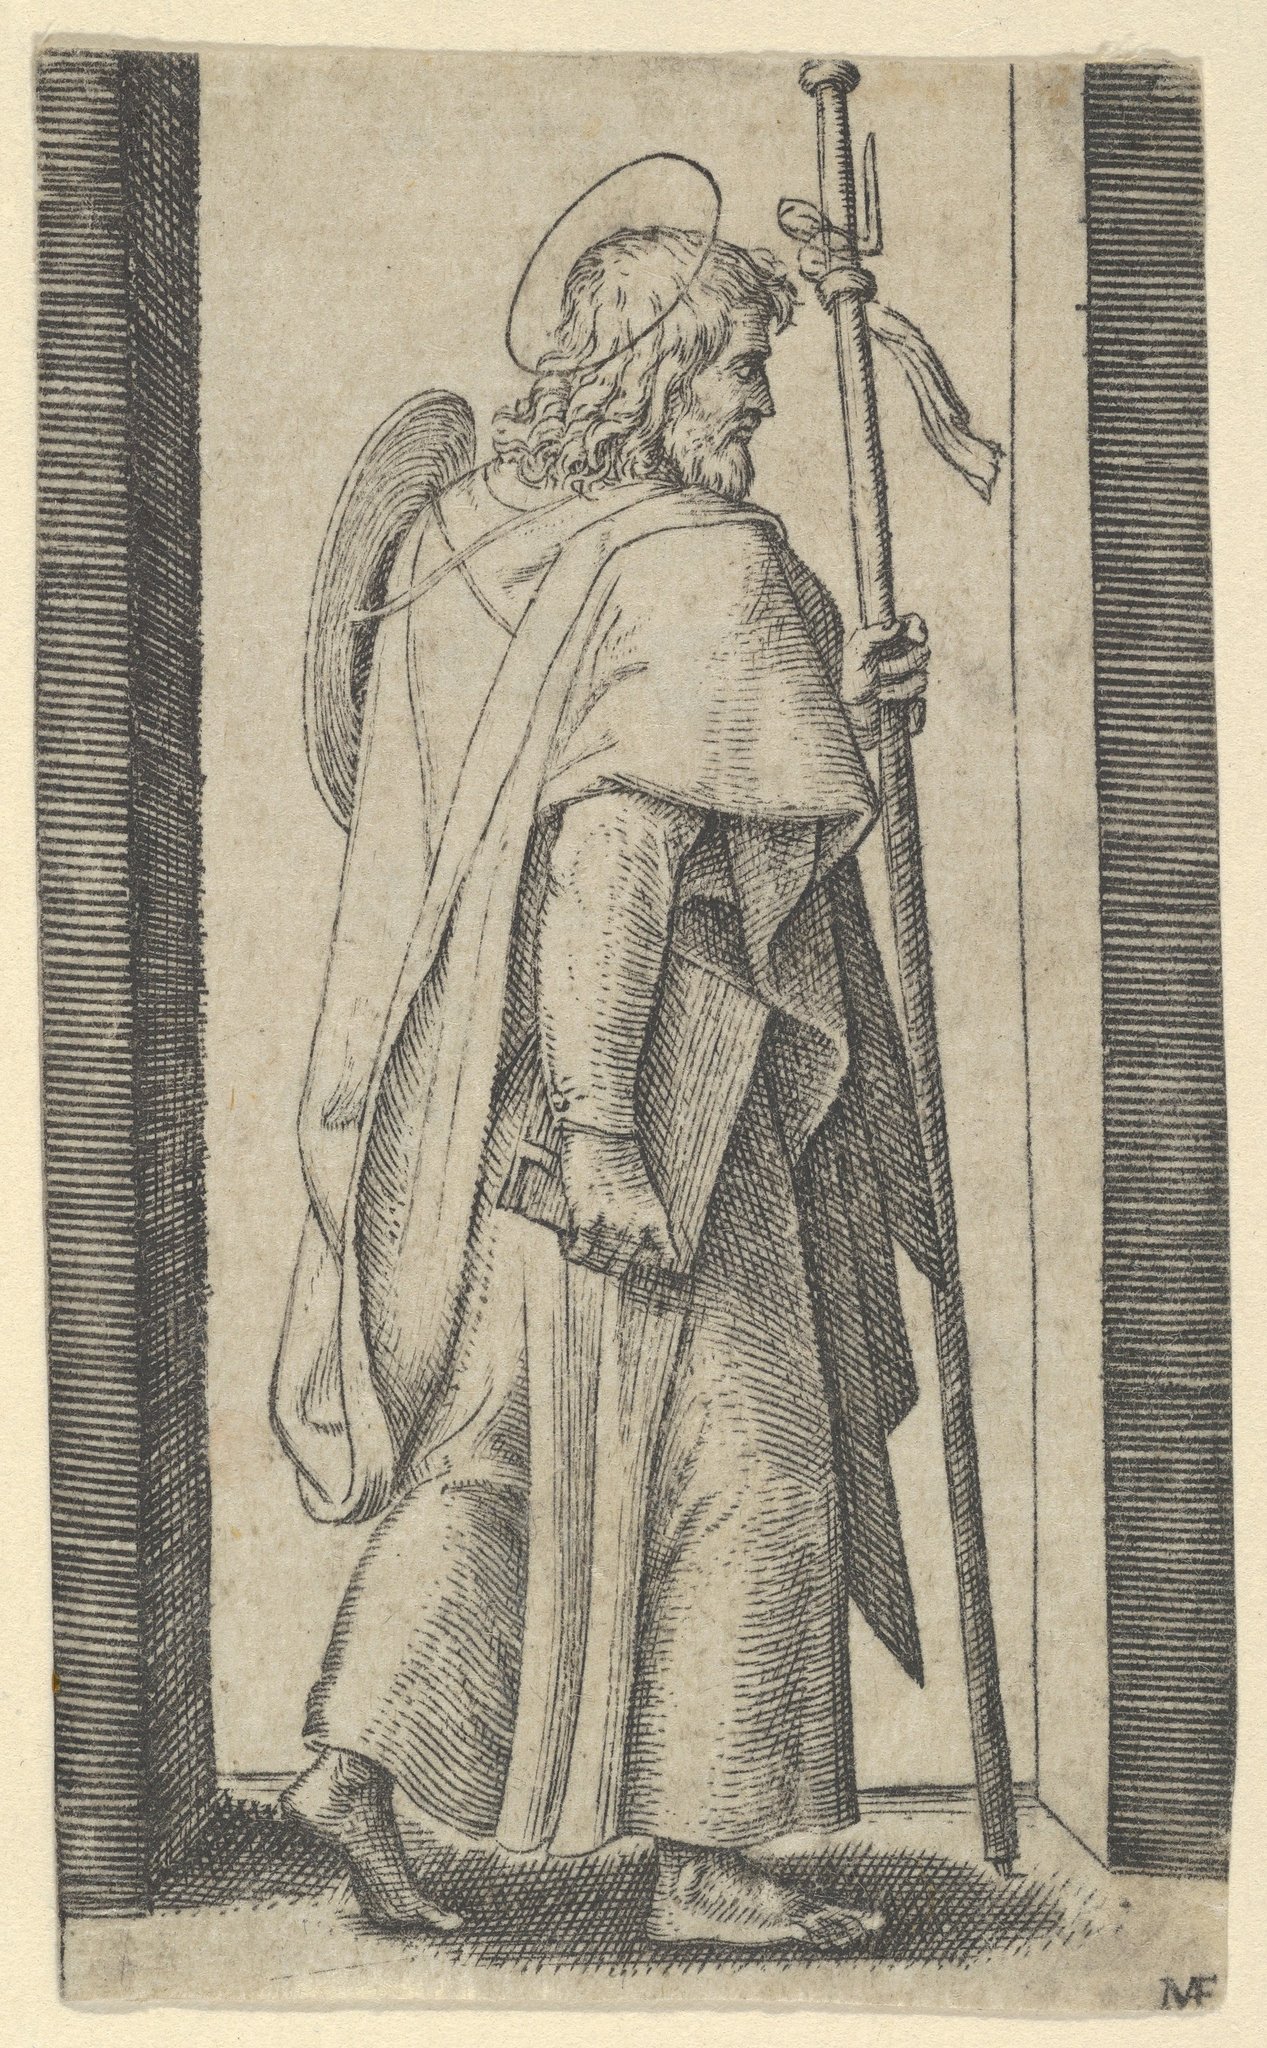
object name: print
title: Saint James Major, book is his right hand, staff in his left facing right, from "Piccoli Santi" (Small Saints)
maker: marcantonio raimondi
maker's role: artist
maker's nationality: italian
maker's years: 1475-1534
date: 1500-1527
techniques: engraving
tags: books,men,saints